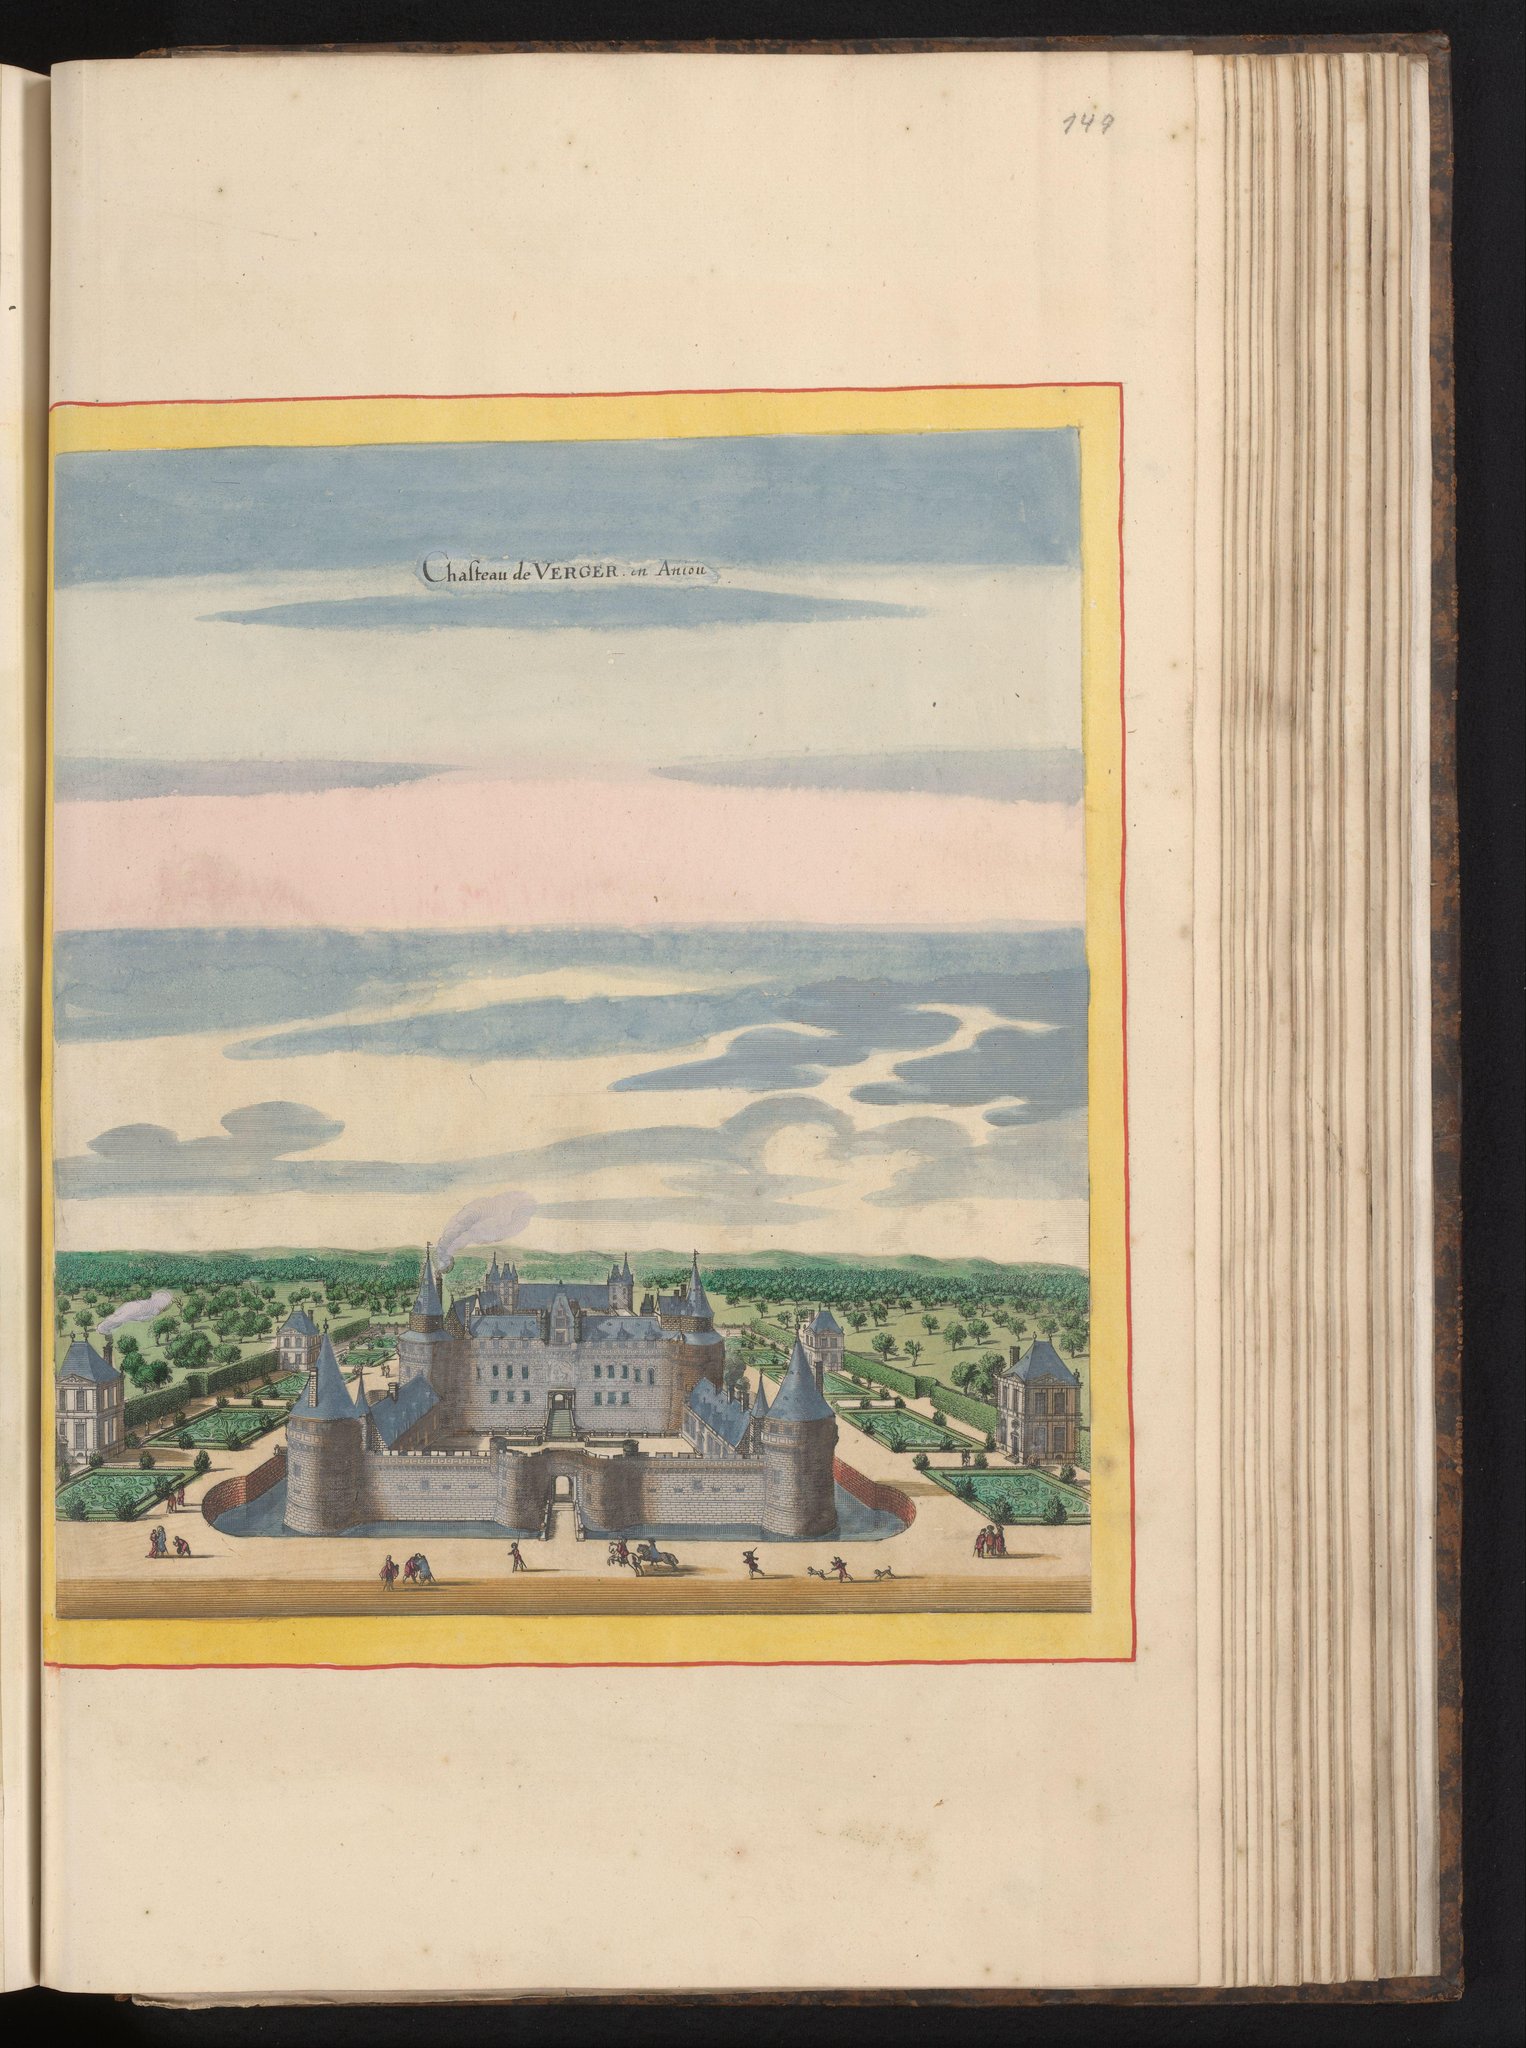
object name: album leaf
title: Gezicht op Château du Verger in Seiches-sur-le-Loir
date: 1657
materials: paper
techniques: engraving, etching, hand coloring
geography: frankfurt am main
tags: castle, landscape with tower or castle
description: Prent uit: Zeiller, Martin. Topographia Galliae. 13 dln. Frankfurt: Caspar Merian, 1657, dl. 7, na p. 70. De titel is uit de originele prent gesneden. Boven de gravure is een deel lucht en wolken (bij)geschilderd, waarin de titel gelijmd is.